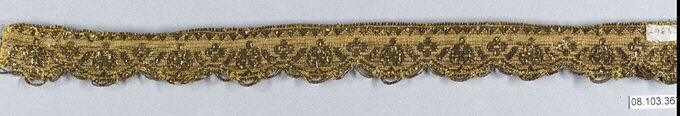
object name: galloon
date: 1601-1800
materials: metal thread